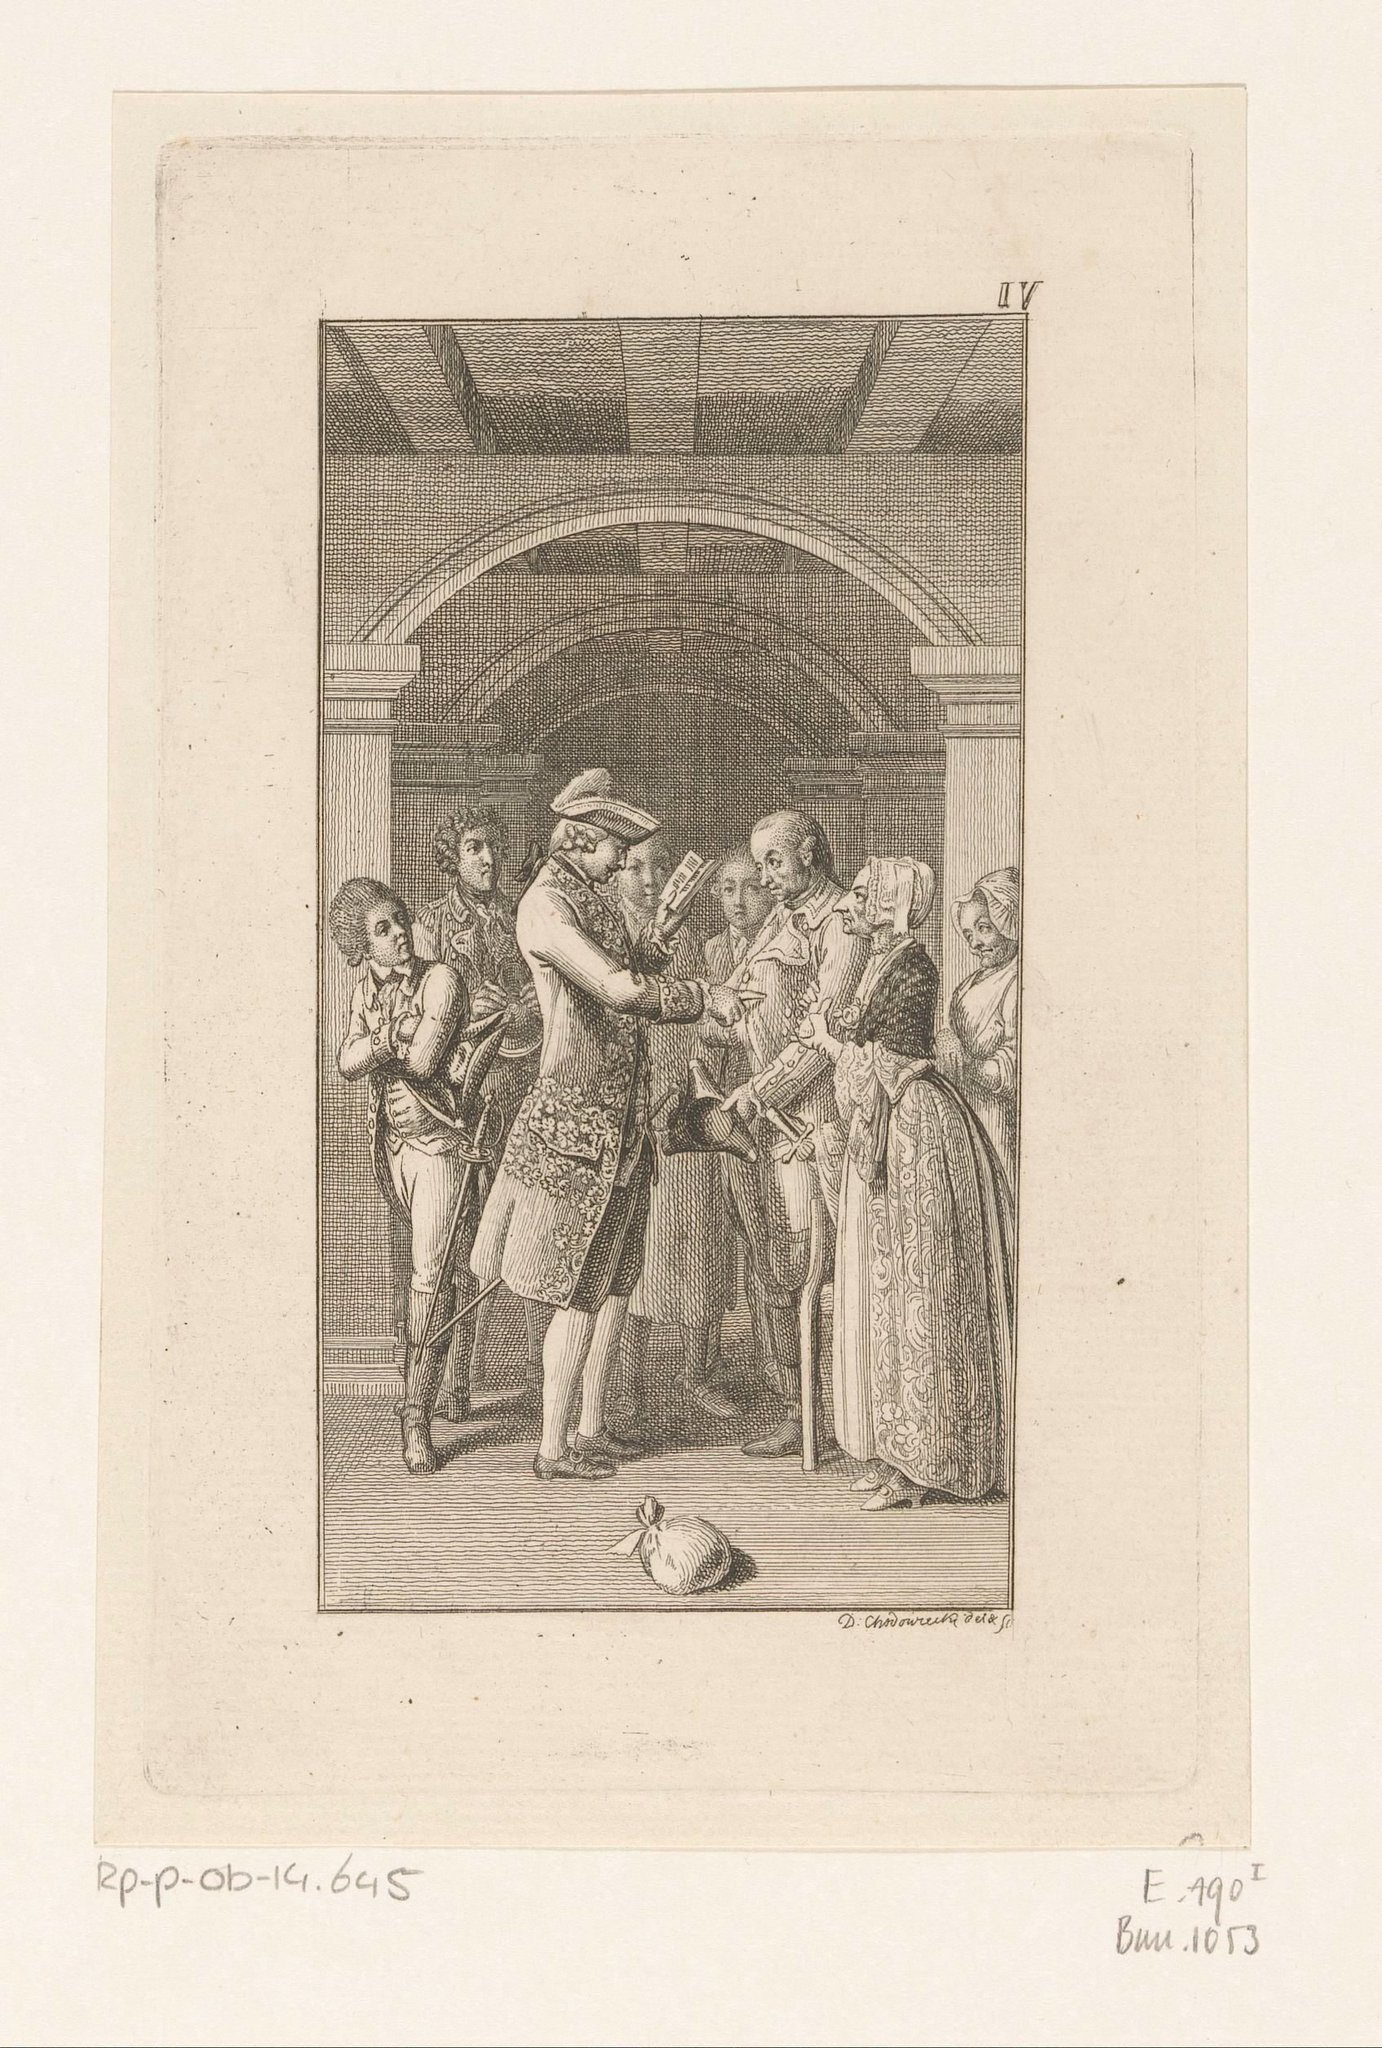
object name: print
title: Uitvoering van het toneelstuk Minna von Barnhelm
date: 1783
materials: paper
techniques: etching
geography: berlin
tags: reading, literature, wooden leg, bag, shed, index finger forwards, pointing, indicating, arm in arm (lovers)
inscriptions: collector's mark: Lugt 2228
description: Prent uit: Müller, Johann Gottwerth. Siegfried von Lindenberg [..]. 3de druk. 4 dln. Leipzig: Carl Friedrich Schneidern, 1784, dl. 4.